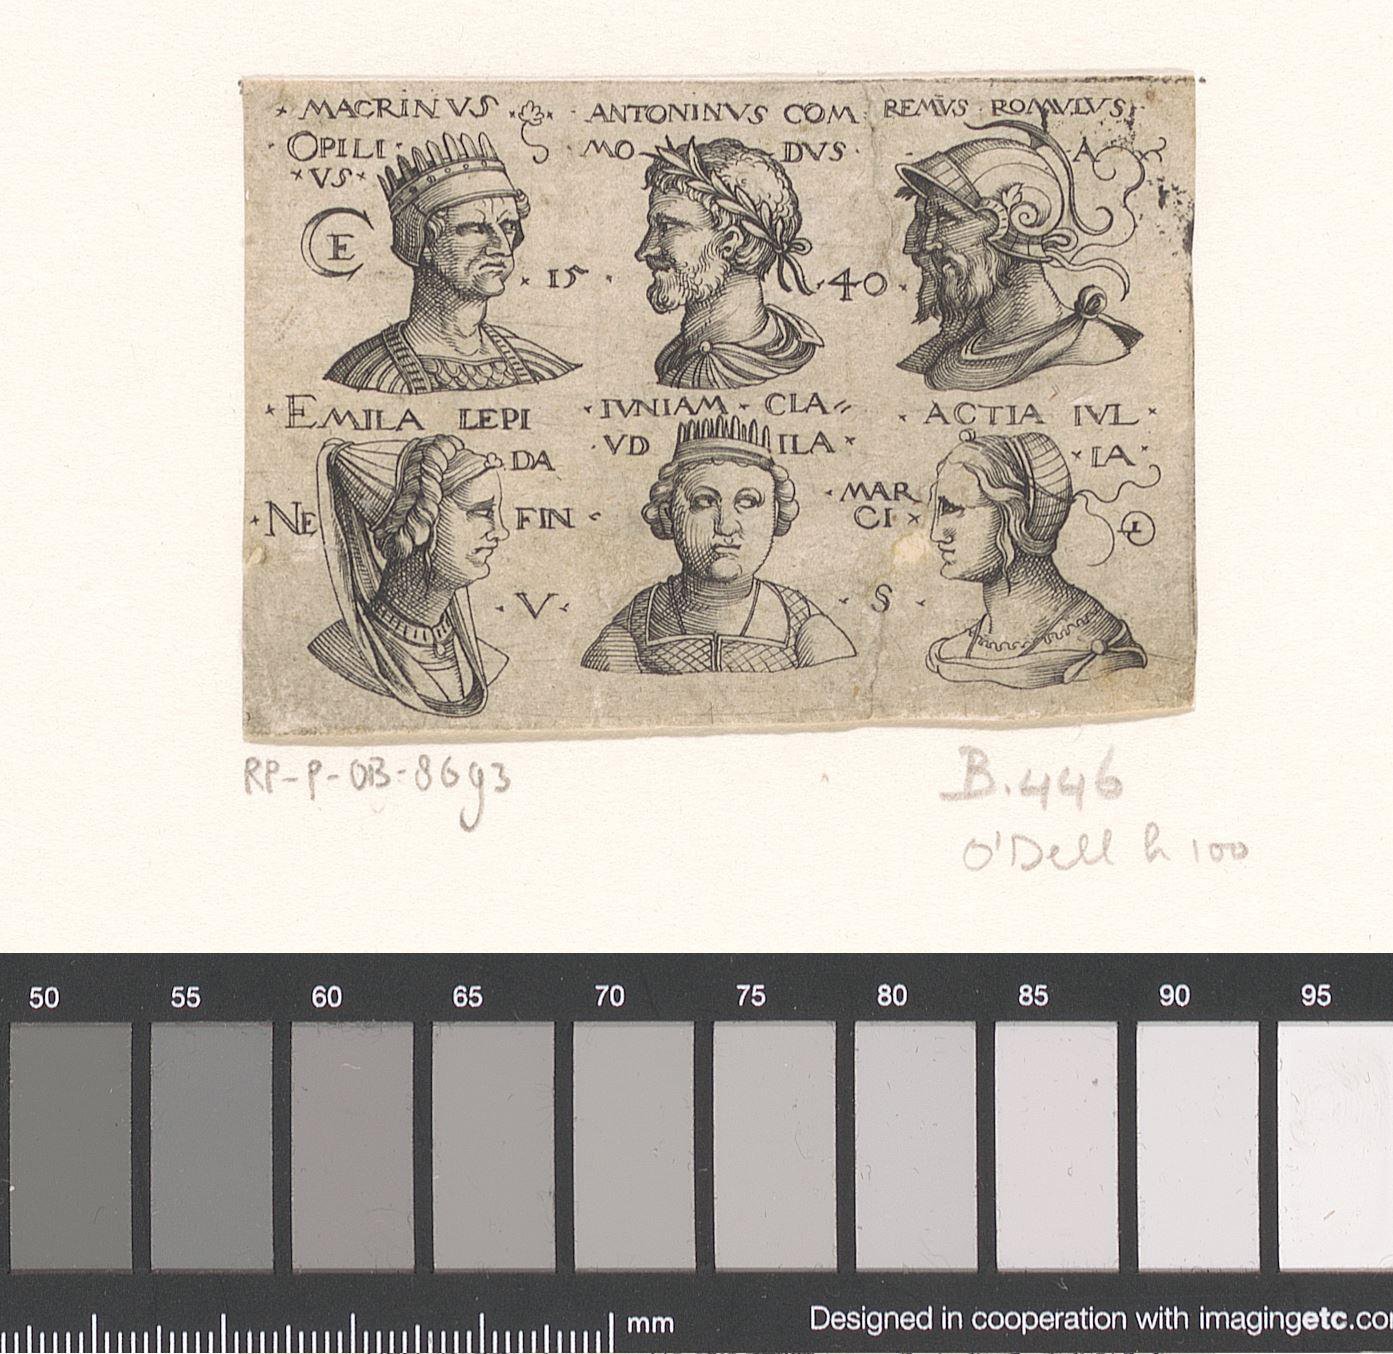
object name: print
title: Acht bustes in medaillons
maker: virgilius solis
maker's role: draughtsman, print maker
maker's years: 1514-1562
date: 1524-1562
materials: paper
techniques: engraving, etching, intaglio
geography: nuremberg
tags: chest, bust, head-gear, ornament ~ medallion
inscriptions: collector's mark: Lugt 2228, number: ‘14’